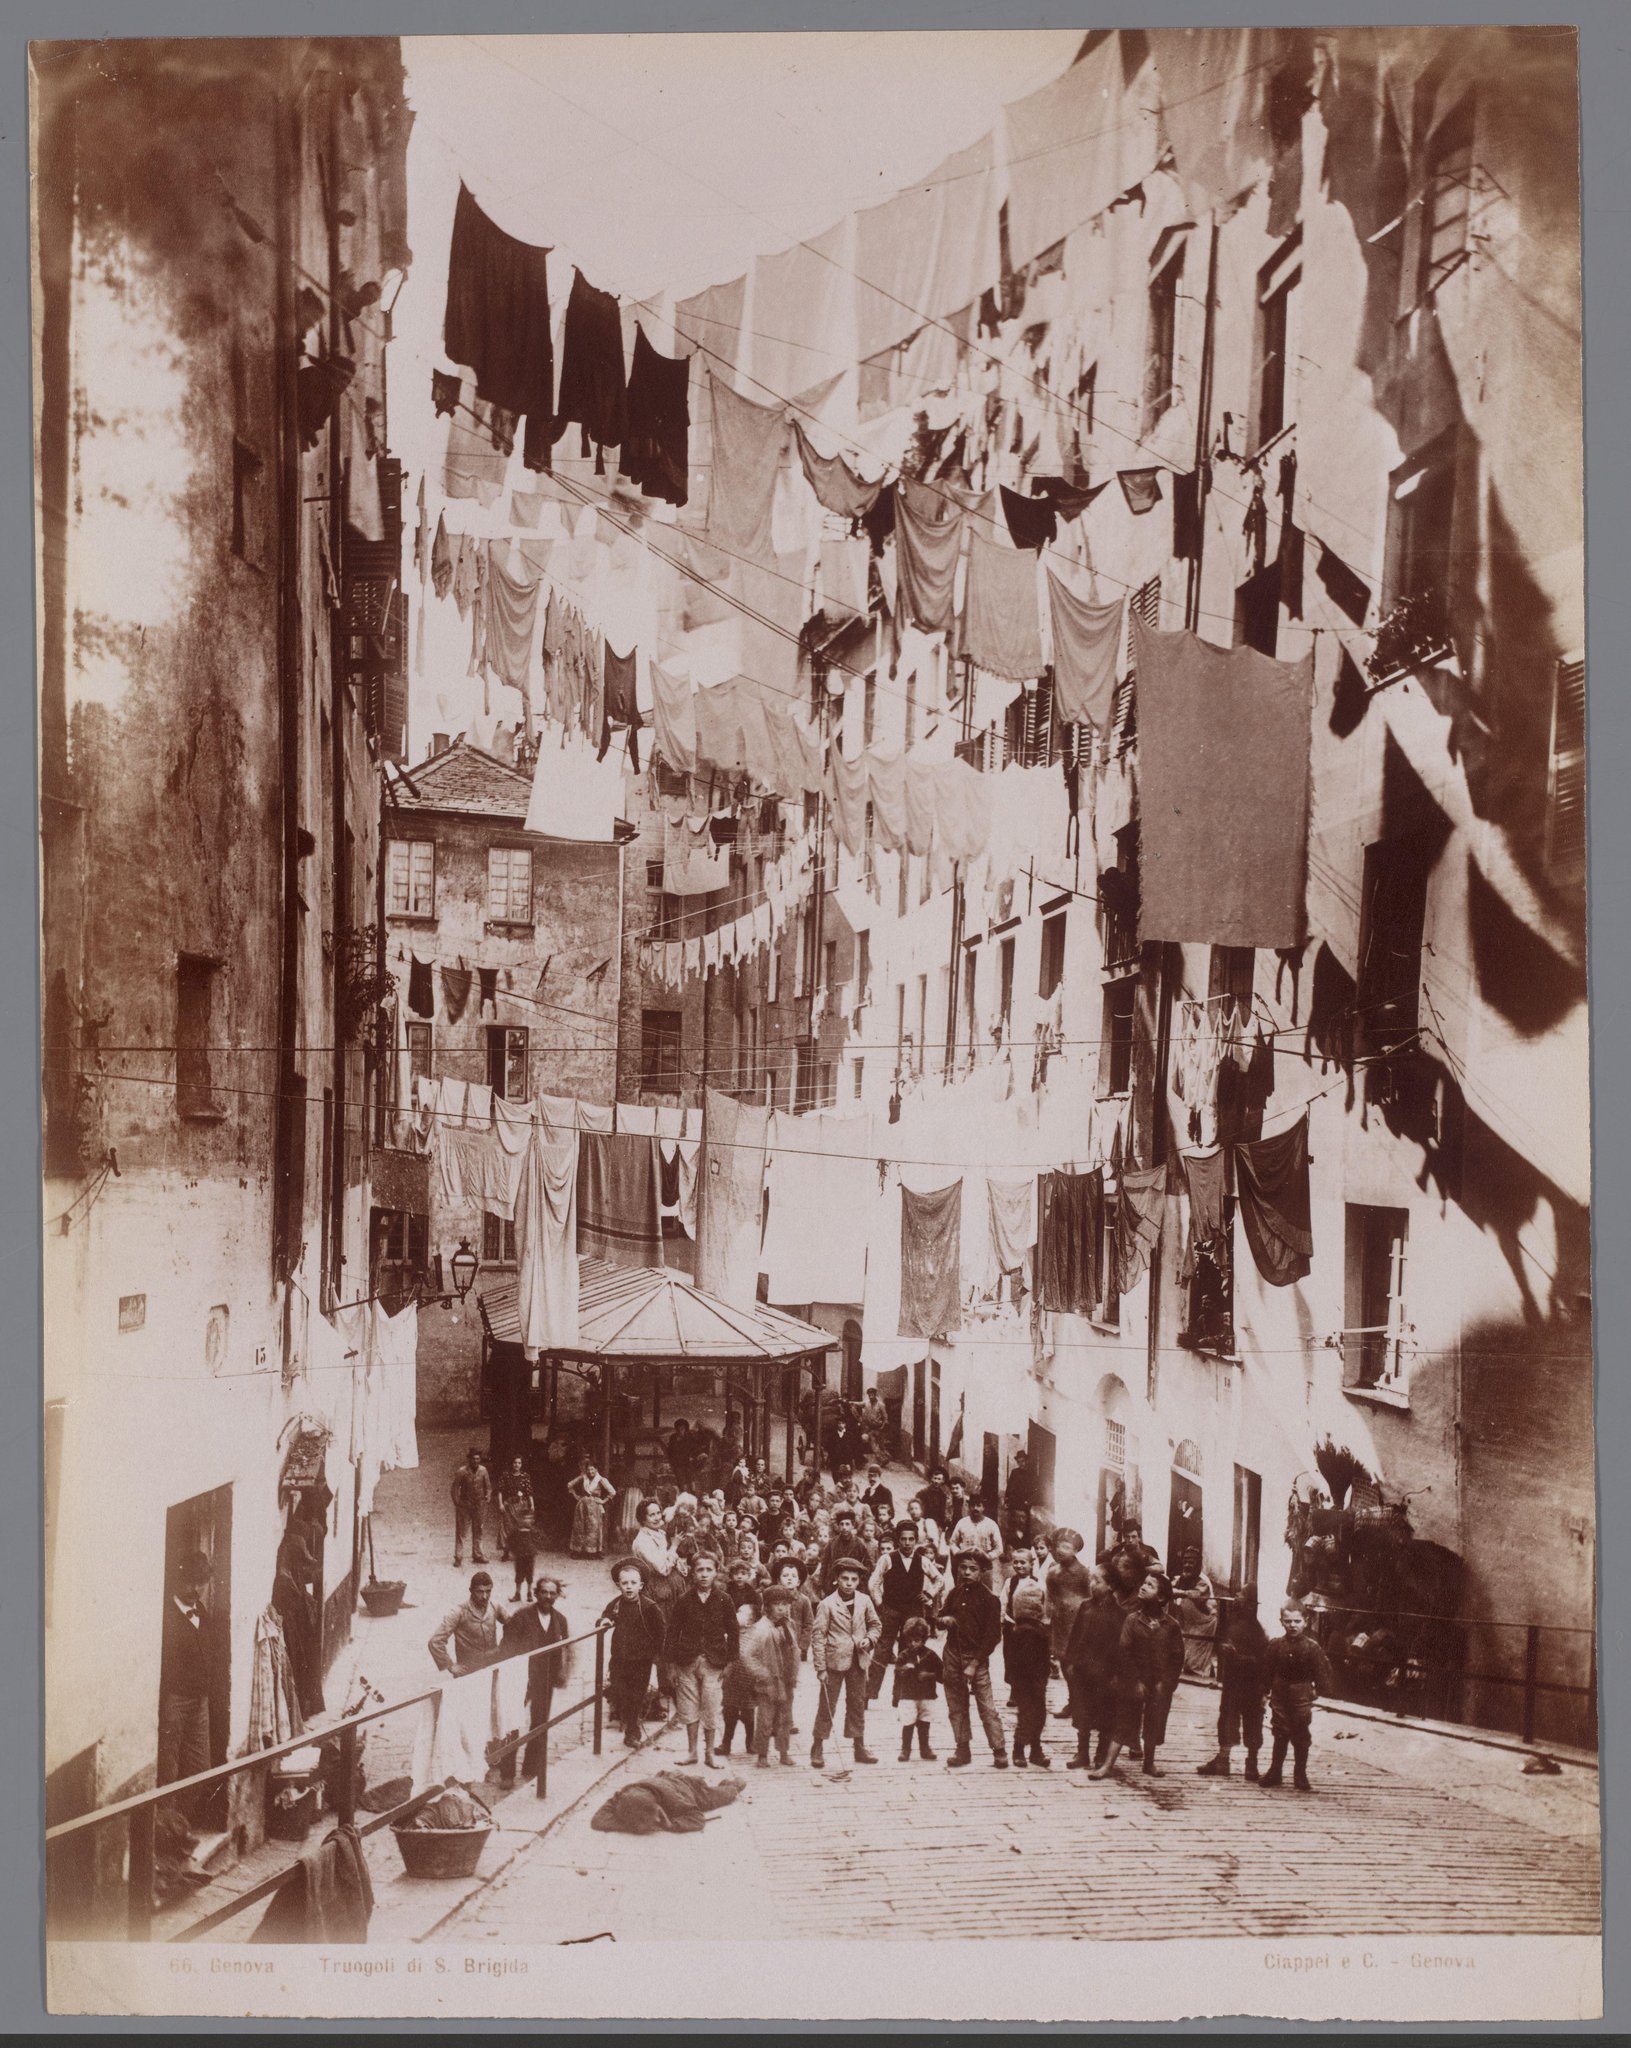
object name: photograph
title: Piazza dei Truogoli di San Brigida in Genua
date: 1860-1900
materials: paper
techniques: albumen print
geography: genoa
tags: street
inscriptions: number: ‘66.’